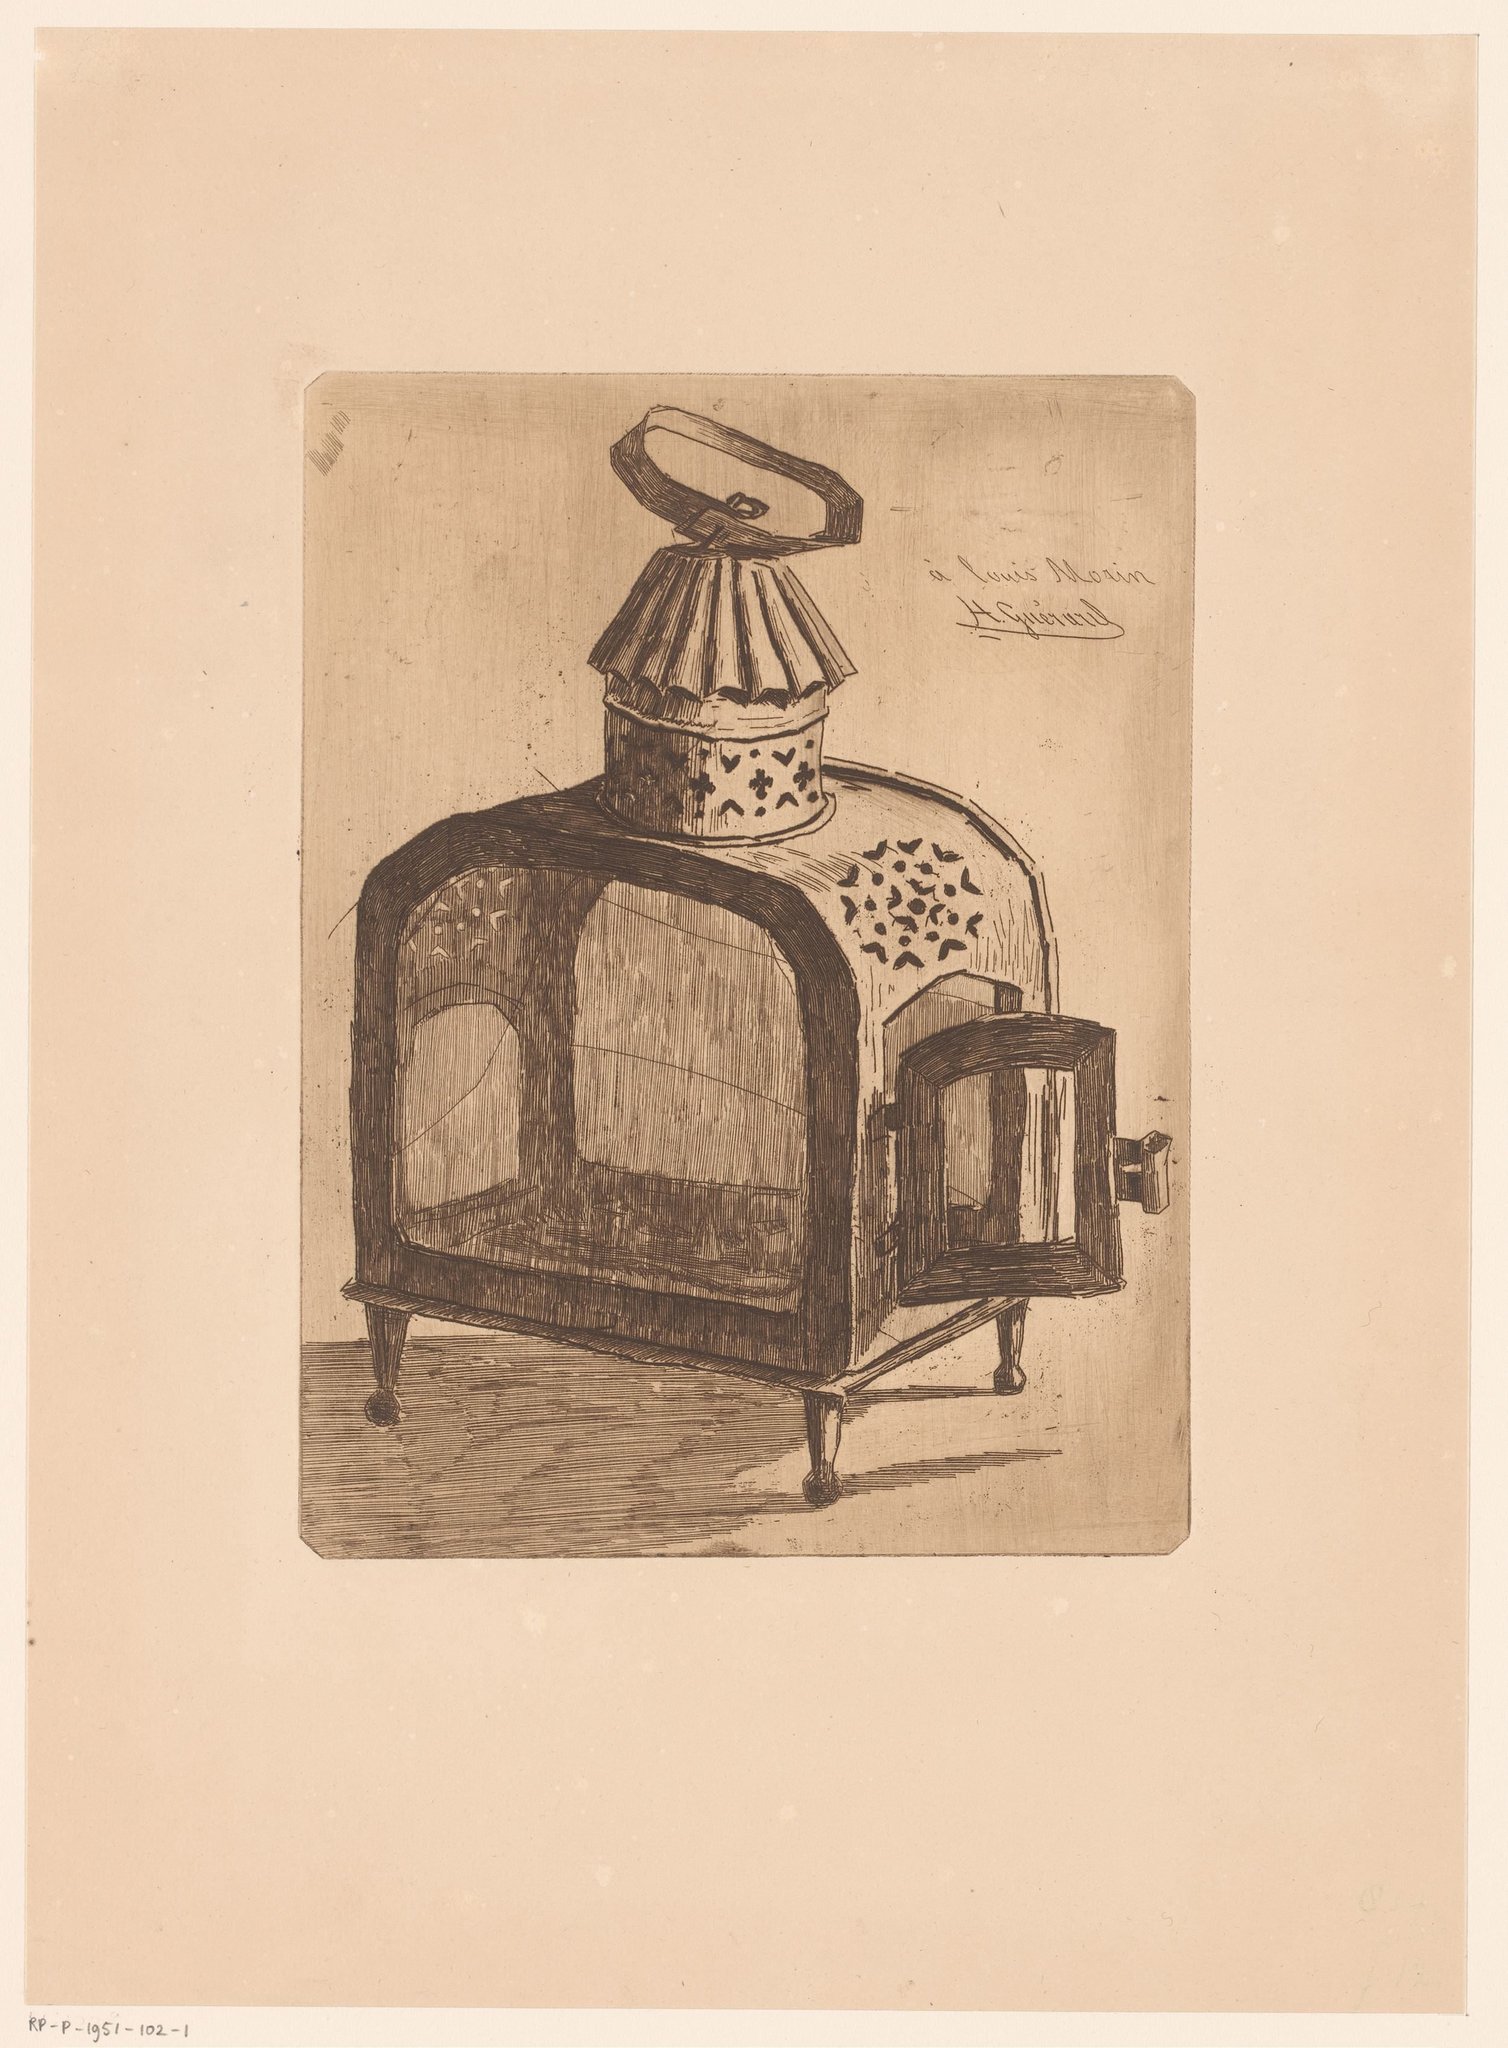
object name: print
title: Lantaarn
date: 1876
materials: paper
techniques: etching, intaglio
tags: lantern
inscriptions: collector's mark: Lugt 2228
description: Maakt waarschijnlijk deel uit van een tiendelige serie met lantaarns.